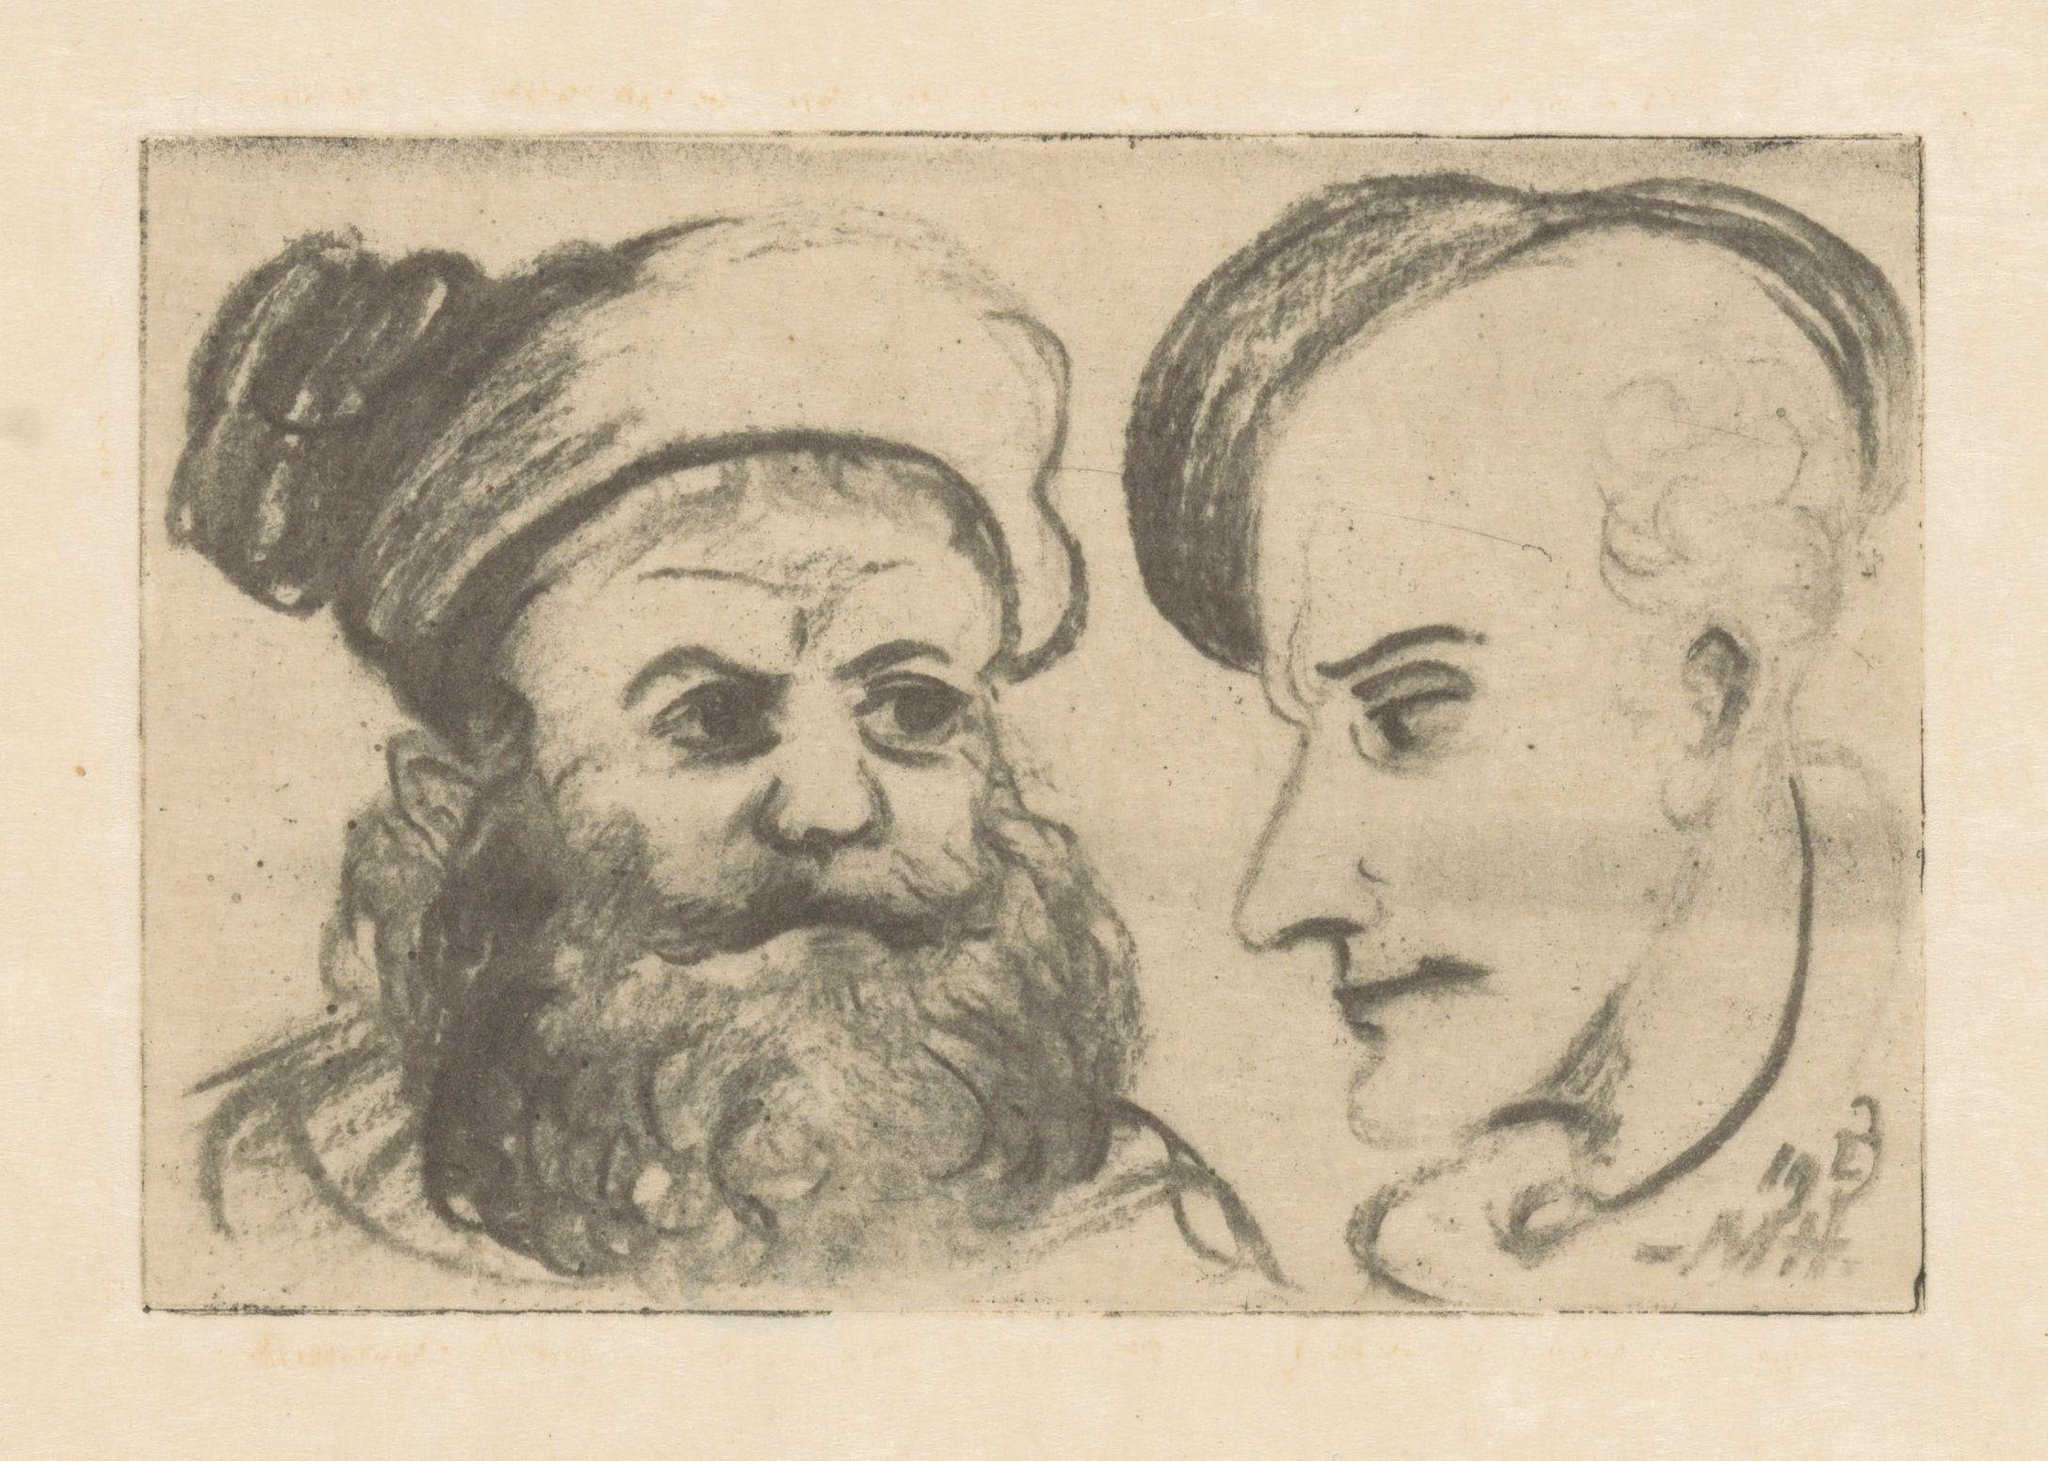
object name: print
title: Kale man en profil en man met baard en muts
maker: marius holleman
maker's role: draughtsman, print maker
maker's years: 1878-1926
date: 1923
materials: paper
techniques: etching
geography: groningen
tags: head-gear: hat, baldness, beard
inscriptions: collector's mark: Lugt 2228